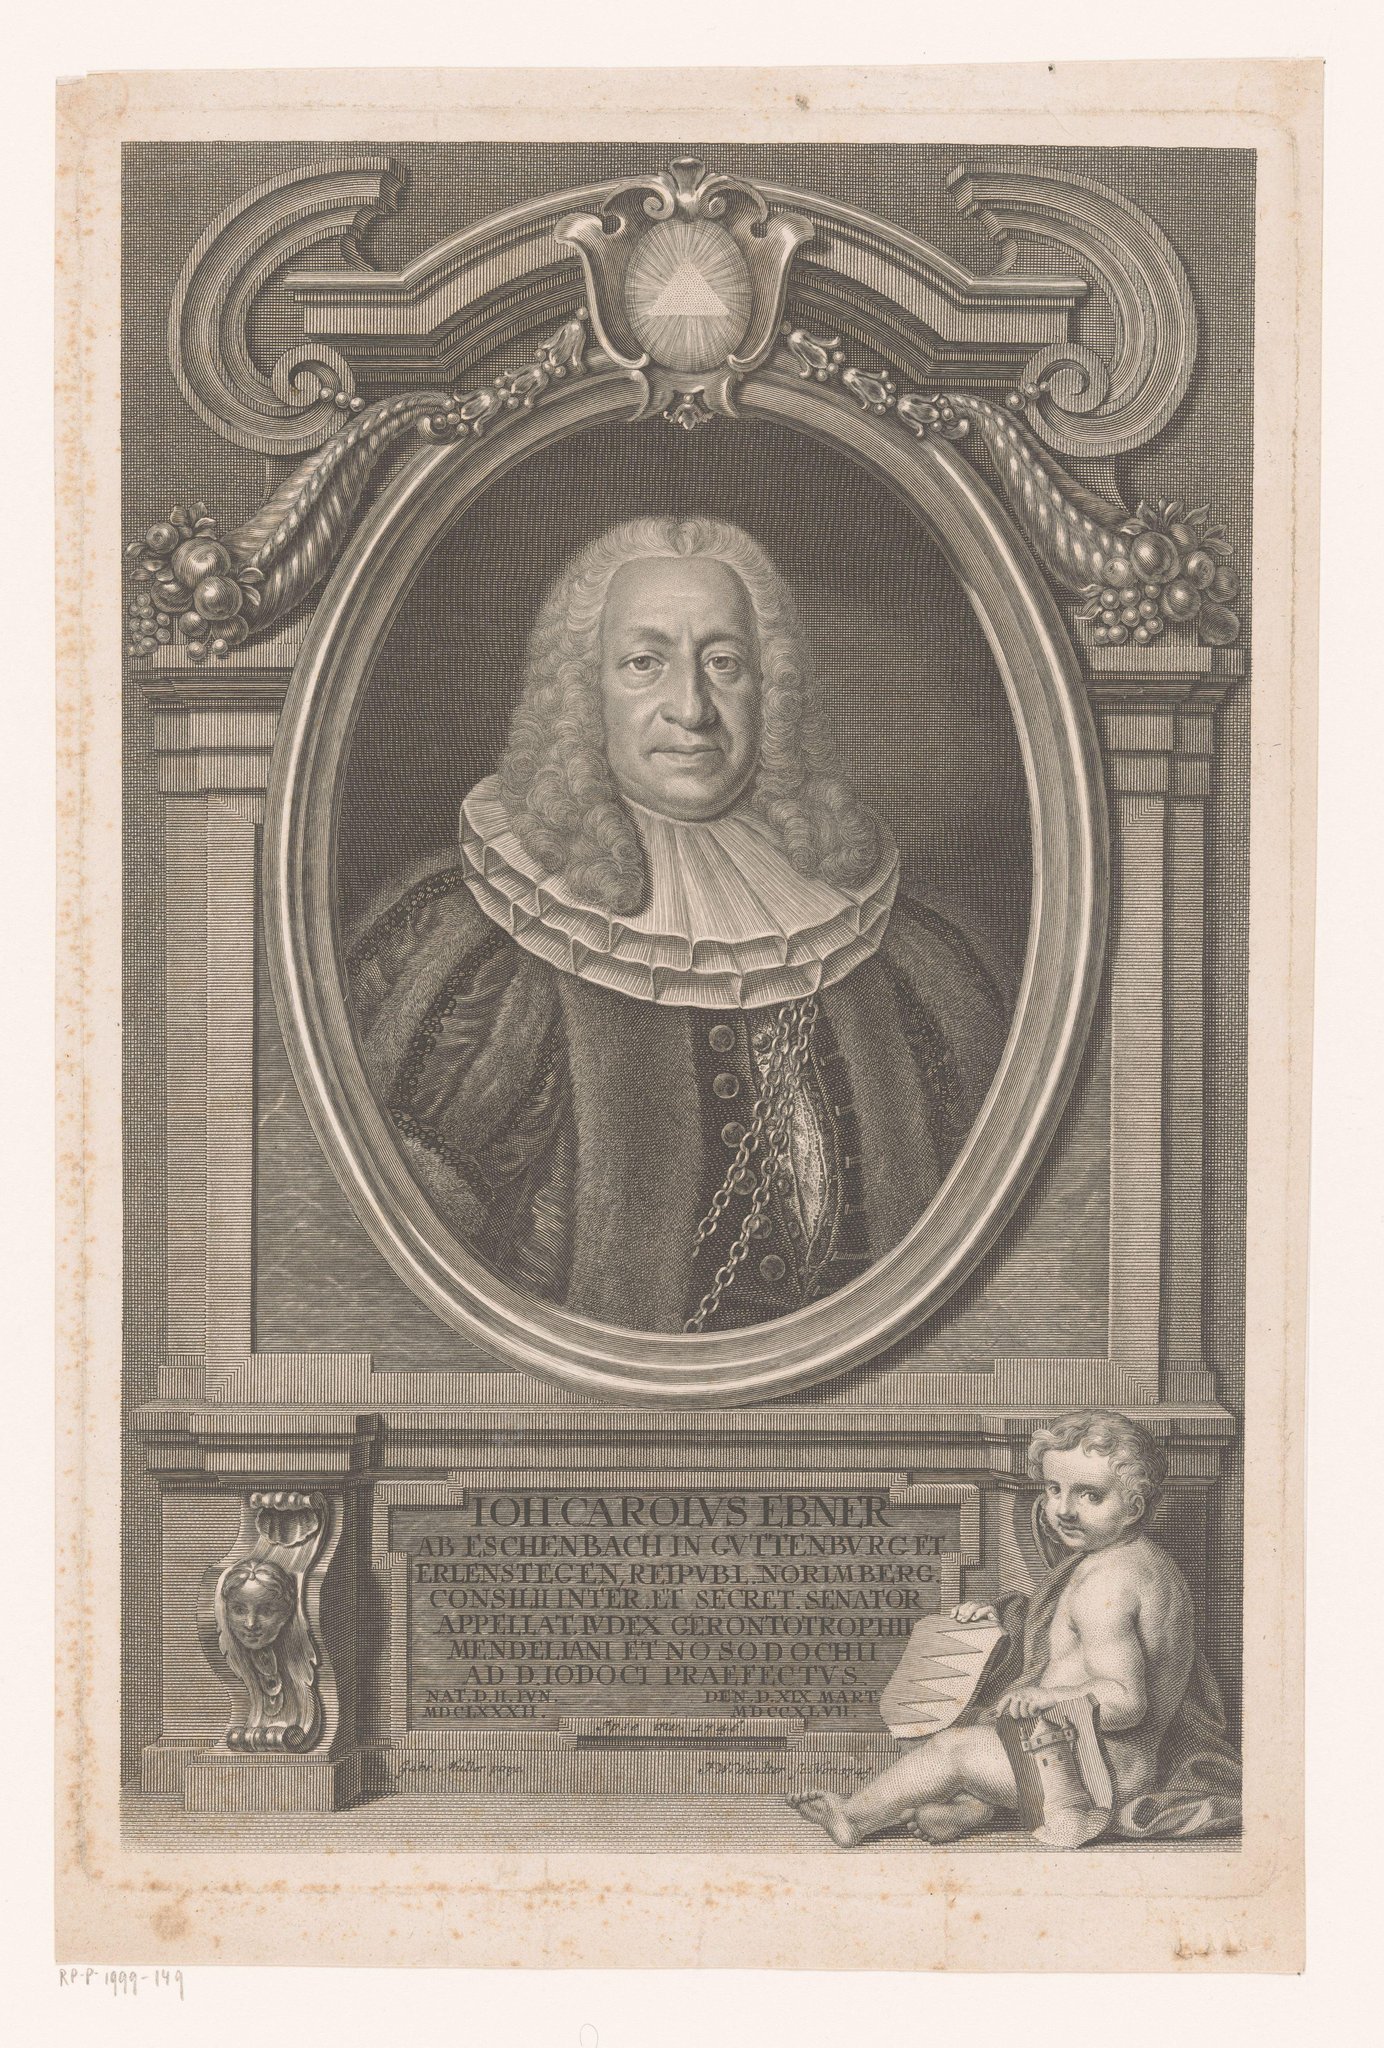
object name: print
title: Portret van Johann Carl Ebner von Eschenbach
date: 1749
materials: paper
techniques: engraving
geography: nuremberg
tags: historical persons, cupids: 'amores', 'amoretti', 'putti'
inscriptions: collector's mark: Lugt 2228